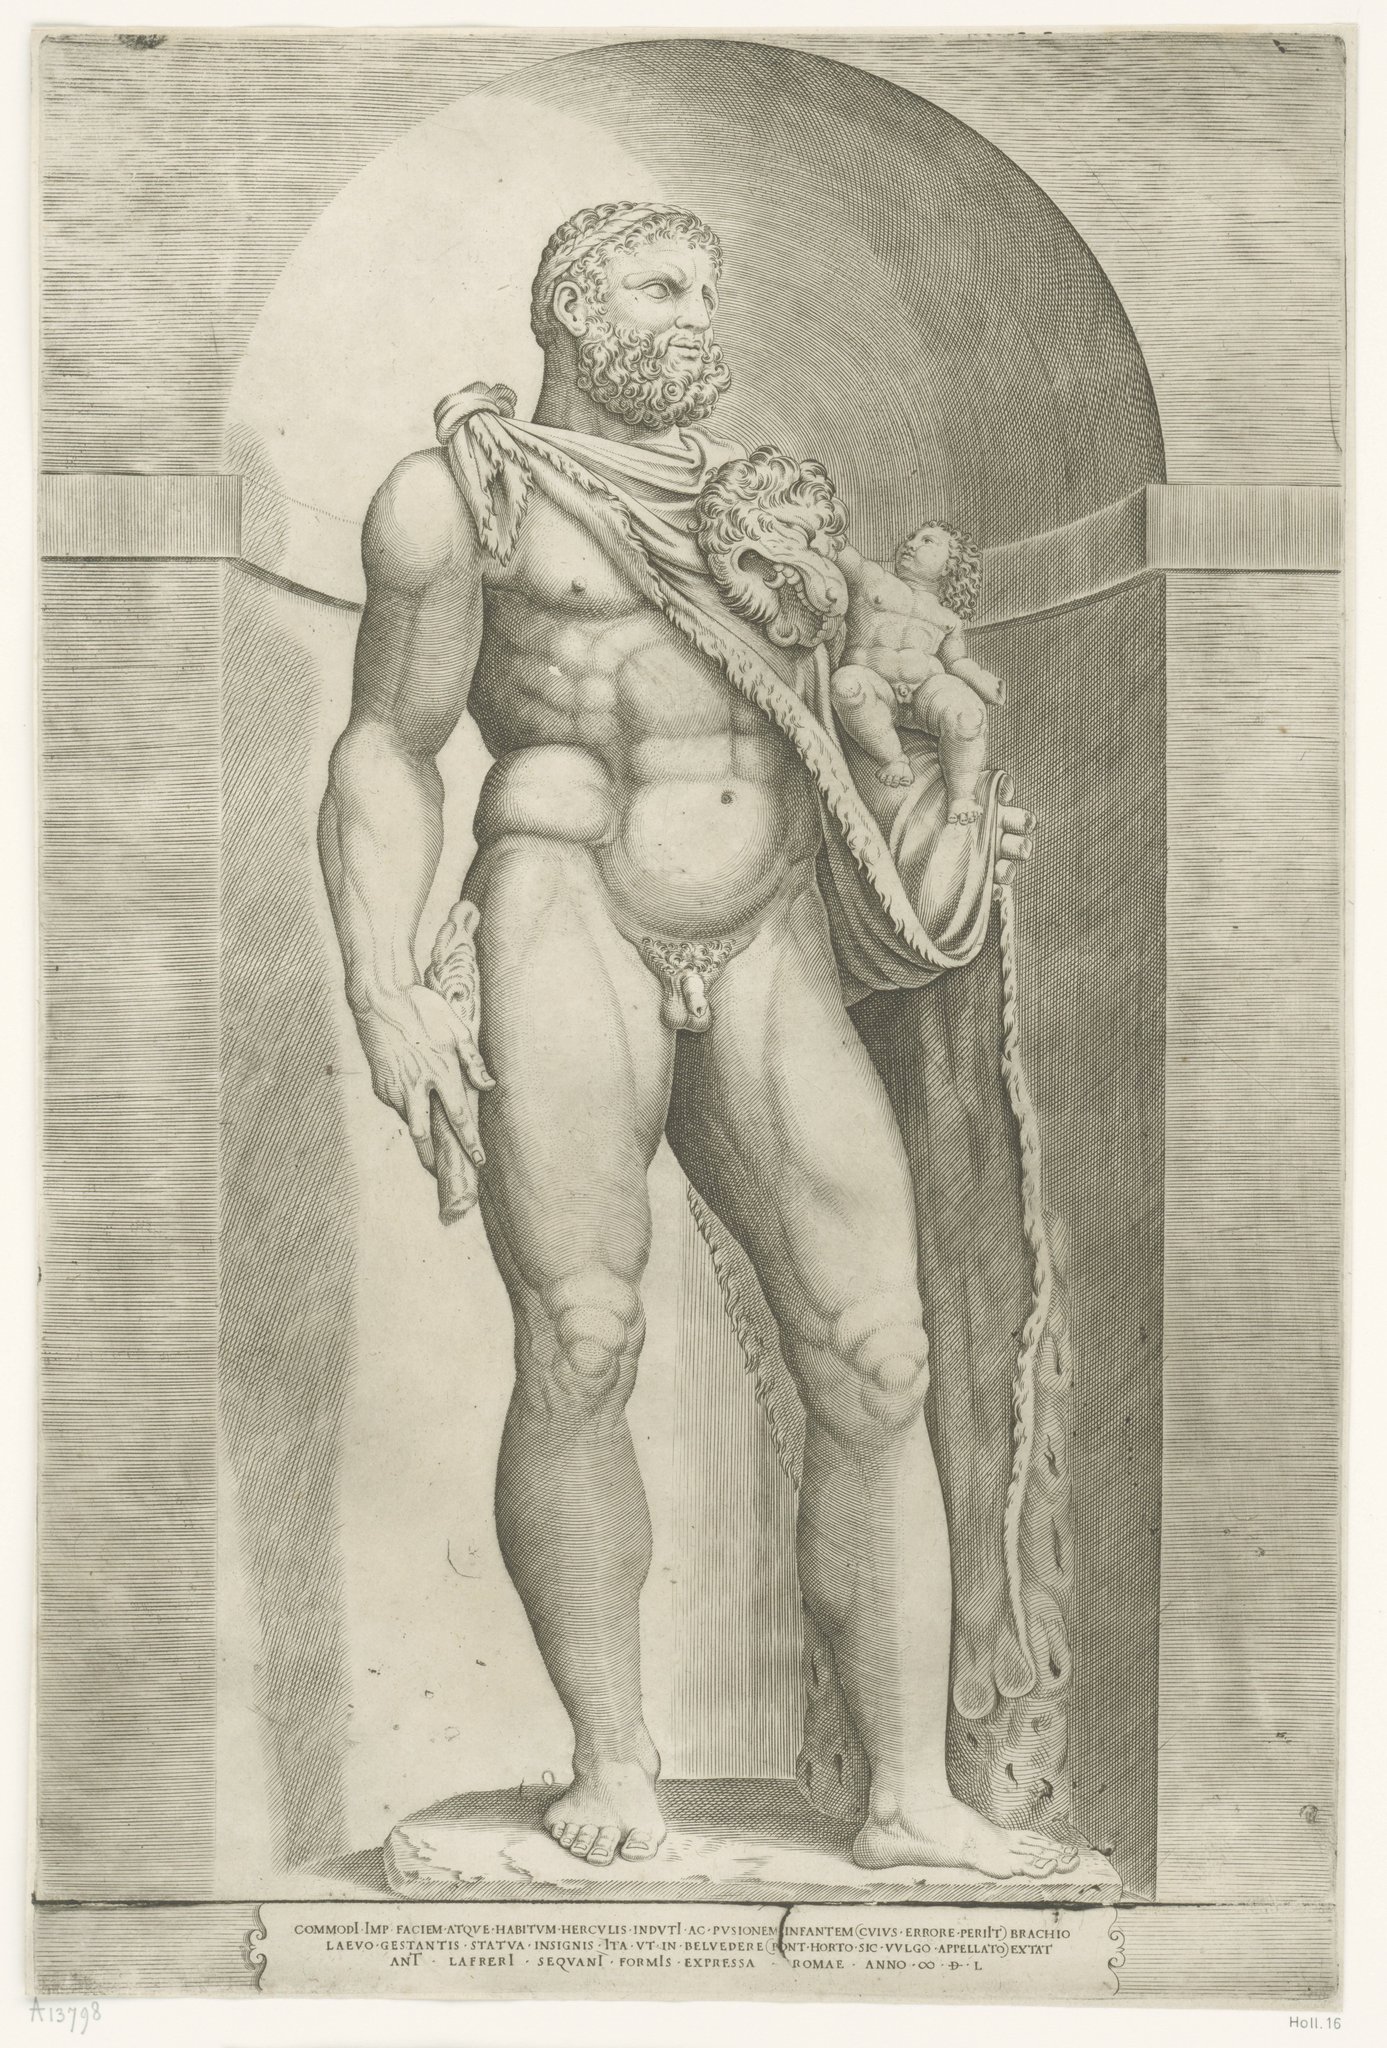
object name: print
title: Standbeeld van Hercules en Telephos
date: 1550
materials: paper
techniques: engraving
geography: rome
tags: (story of) hercules (heracles), piece of sculpture, reproduction of a piece of sculpture, (story of) commodus the roman emperor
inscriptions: collector's mark: Lugt 2228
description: Standbeeld van keizer Commodus als Hercules. Hercules is naakt en zwaargebouwd. Hij draagt zijn leeuwenhuid als mantel. Op zijn linkerarm zit zijn zoon Telephos. Het beeld staat nu in het Vaticaans museum. De prent heeft een Latijns onderschrift.